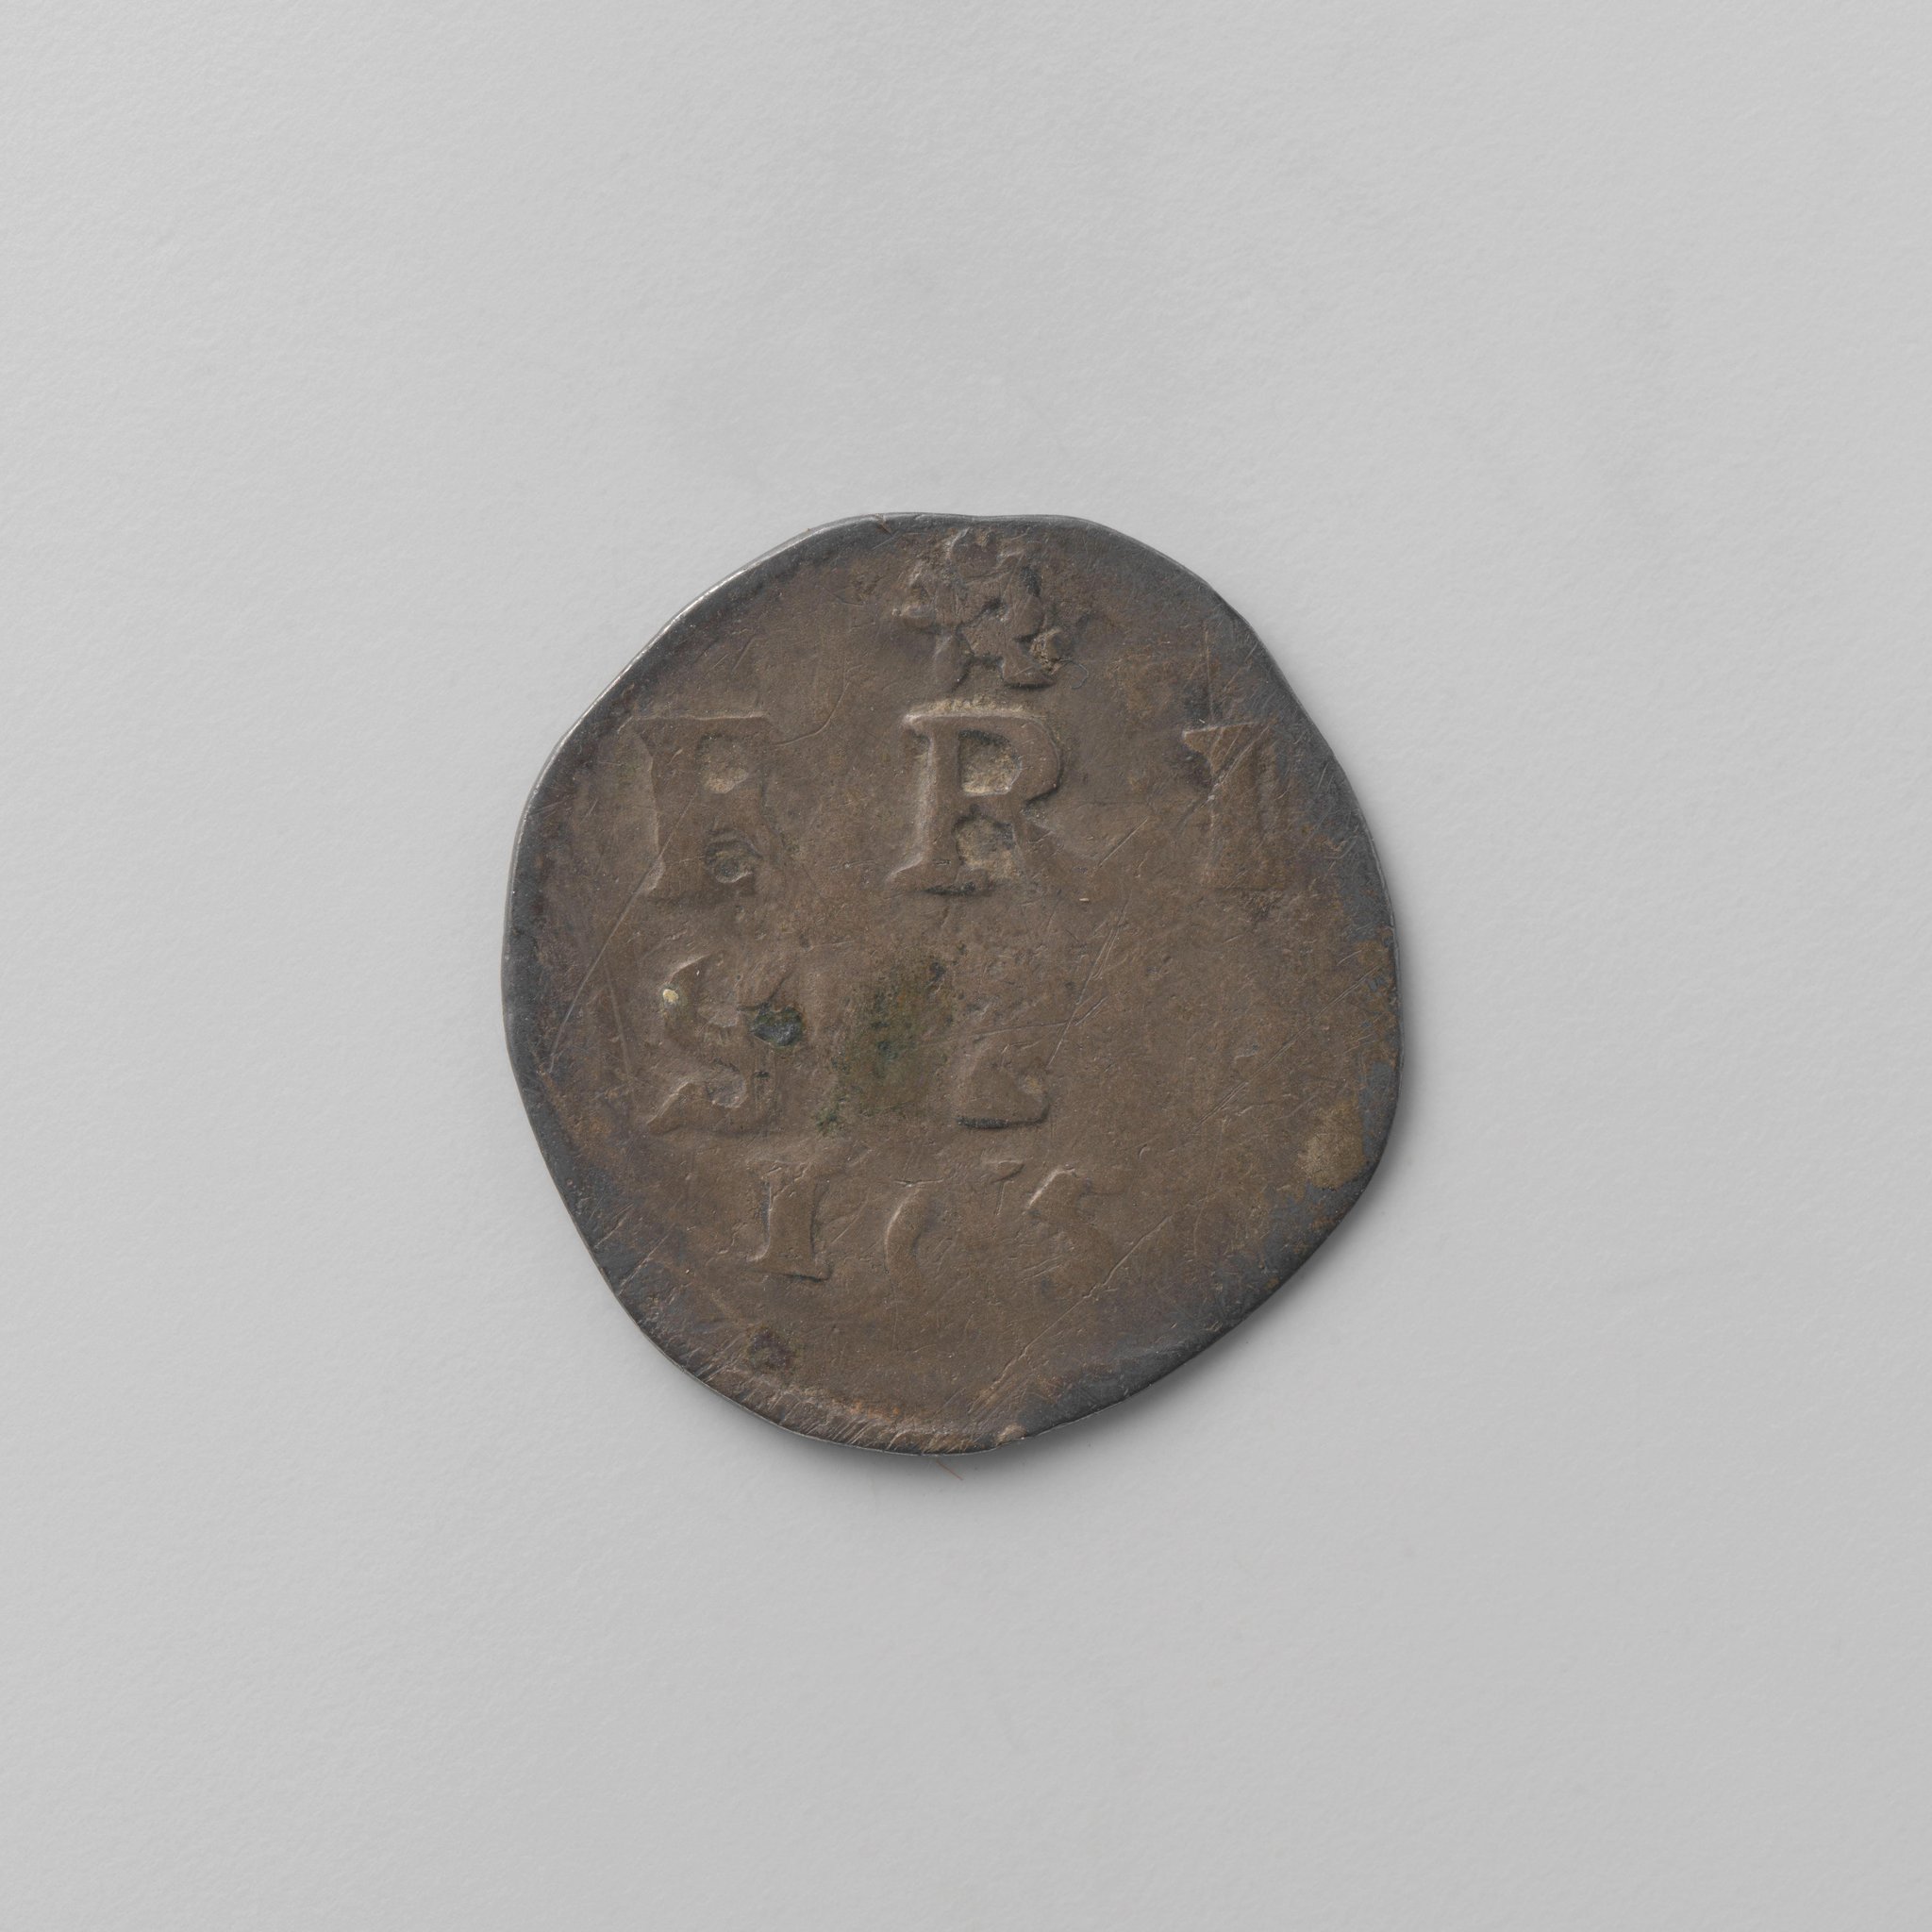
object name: coin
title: Friese dubbele stuiver, 1653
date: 1653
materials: silver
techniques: striking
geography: leeuwarden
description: Zilveren munt. Voorzijde: tussen waarde-aanduiding 2 S klimmende leeuw naar links, in linkerklauw pijlenbundel, in rechterklauw zwaard. Keerzijde: Onder muntteken opschrift in twee regels. Daaronder jaartal.